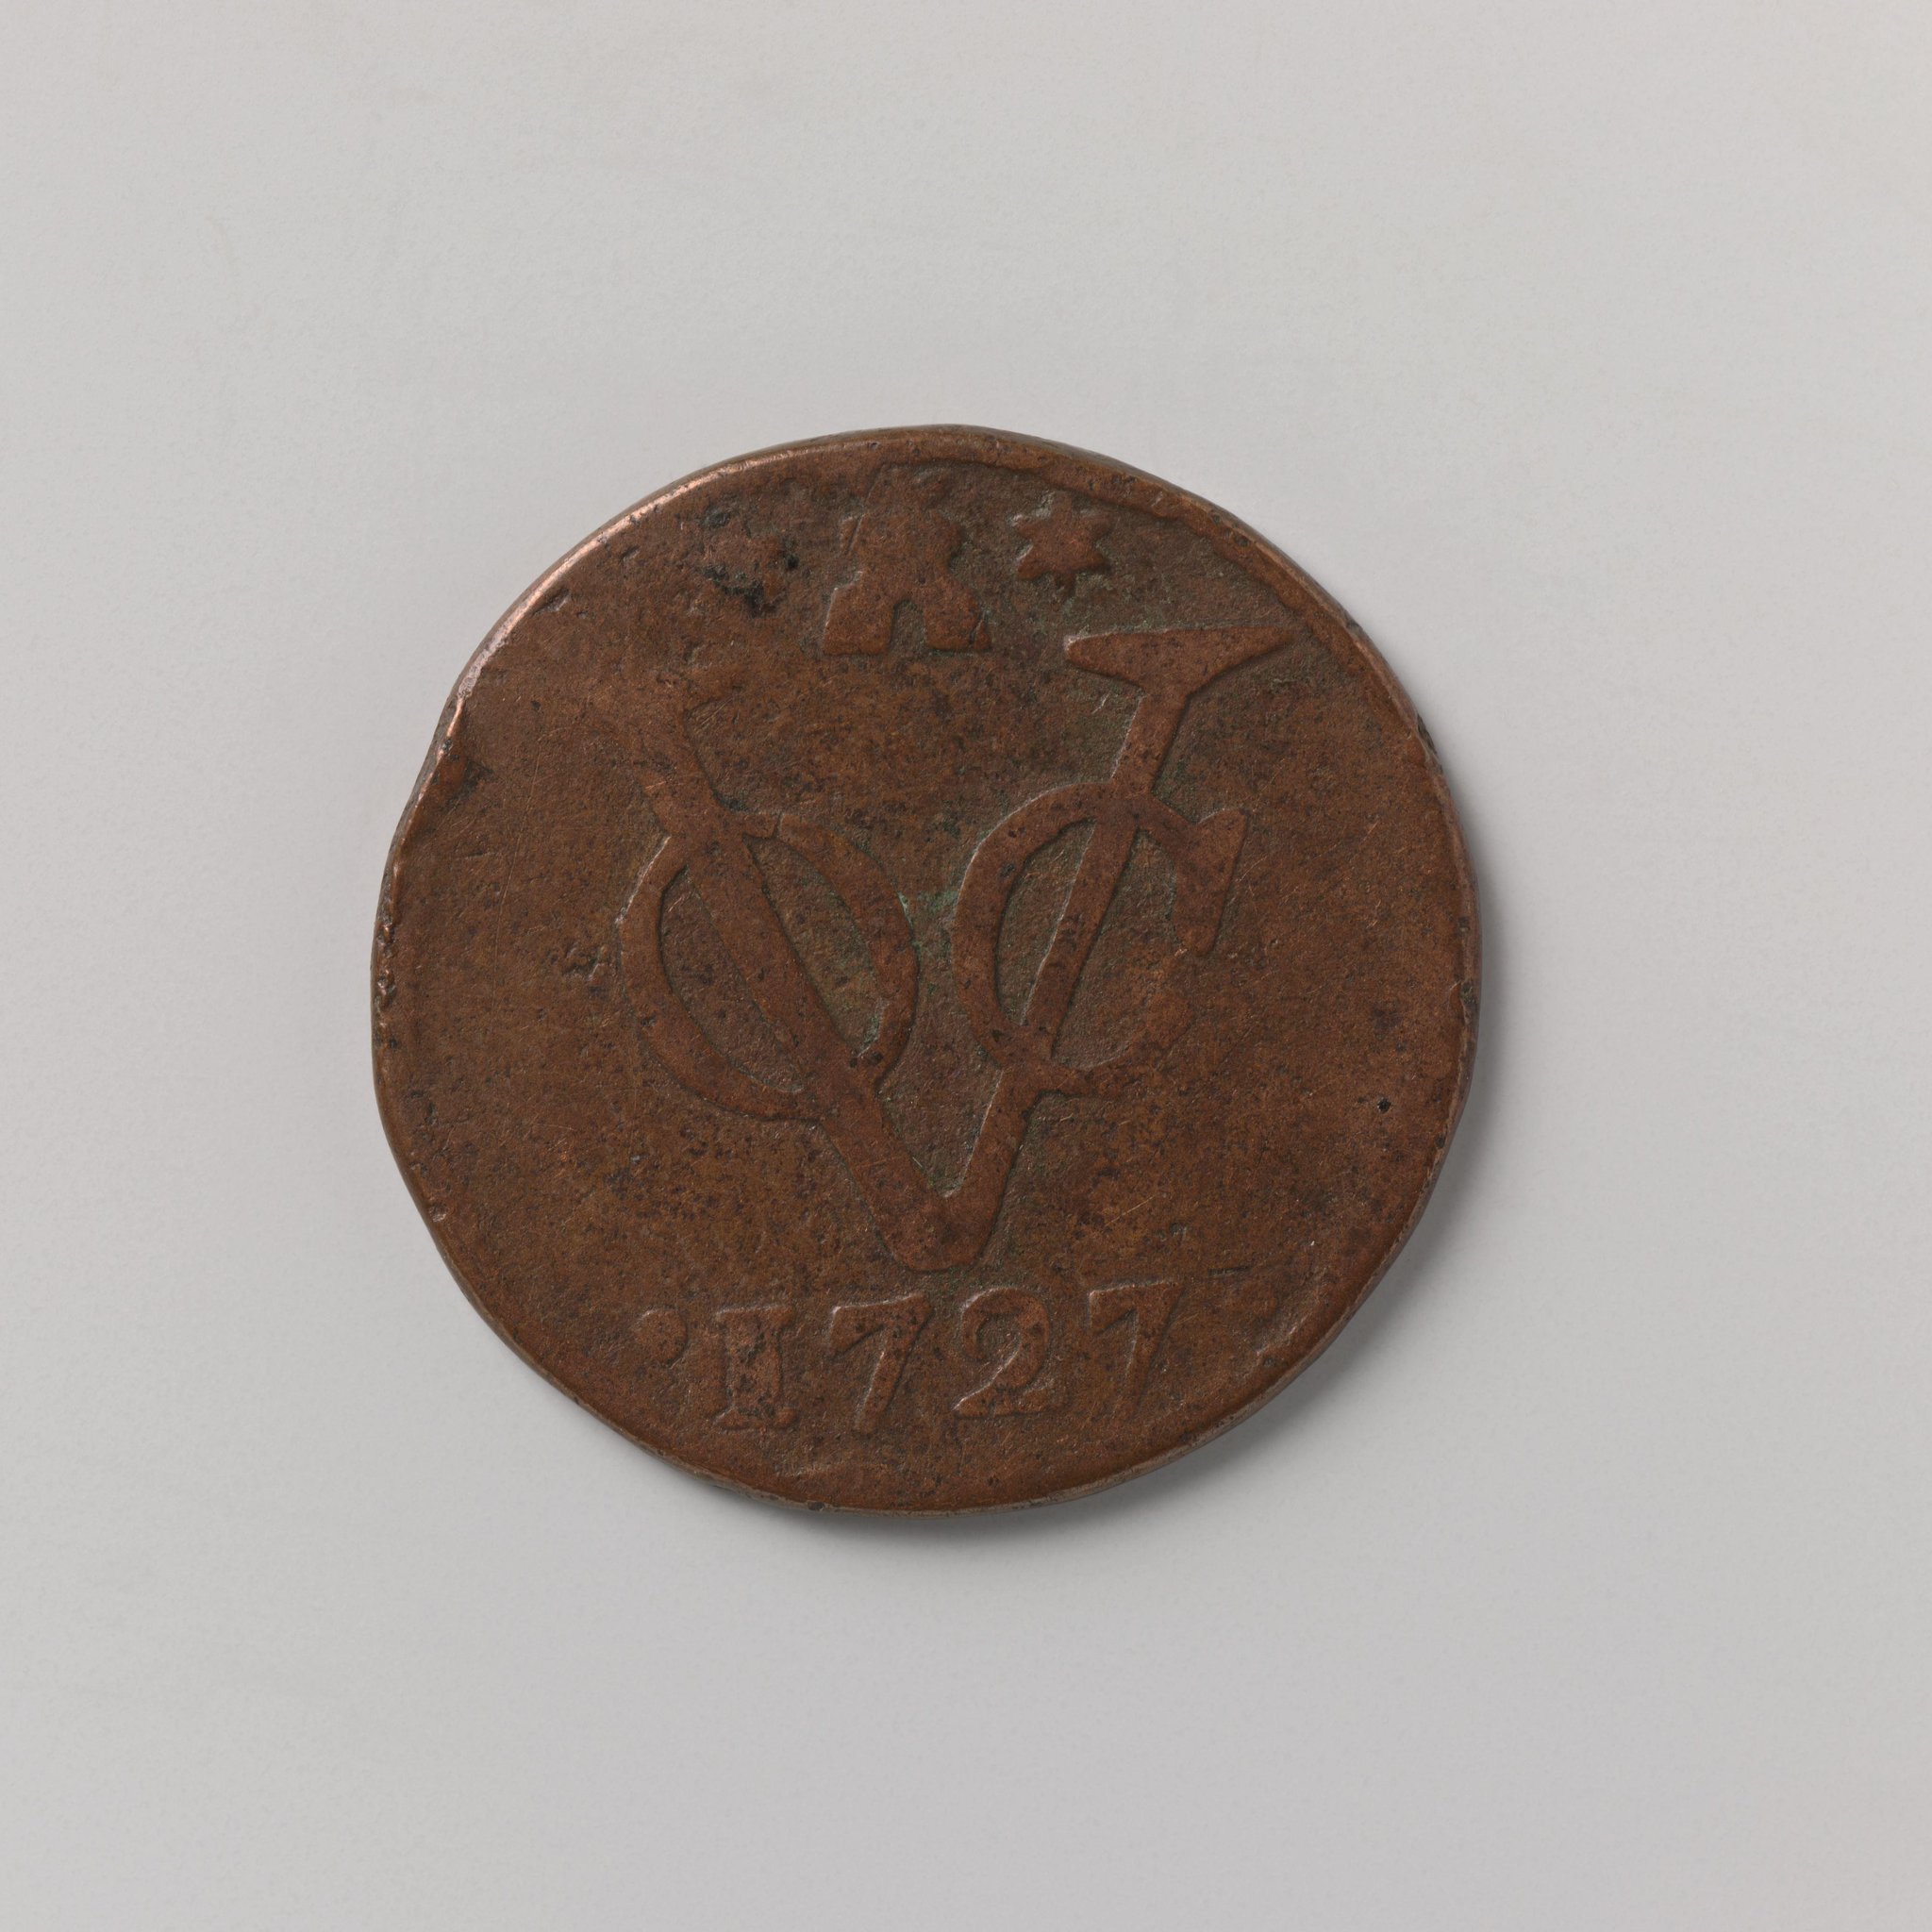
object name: coin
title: VOC, duit Zeeland, 1727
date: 1727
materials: copper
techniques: striking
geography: middelburg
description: Koperen munt. Voorzijde: gekroond ingebogen wapenschild van Zeeeland en omschrift. Keerzijde: monogram van de VOC, waarboven muntteken en waaronder jaartal. Gladde rand.